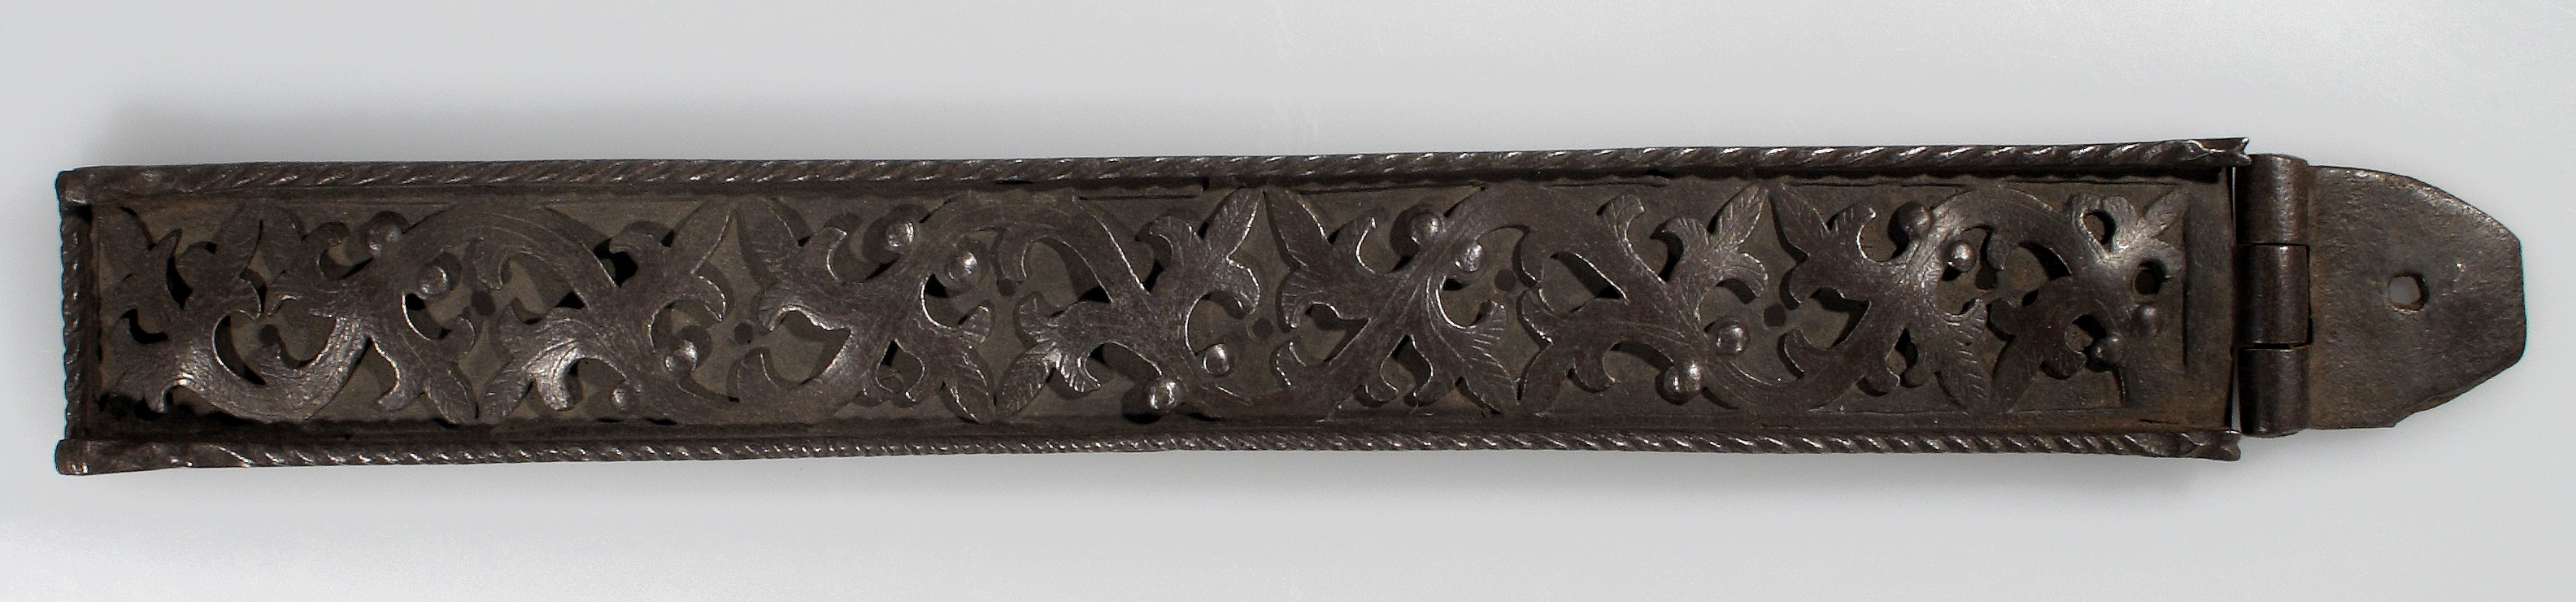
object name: hinge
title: Strap Hinge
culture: european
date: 1401-1600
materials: iron